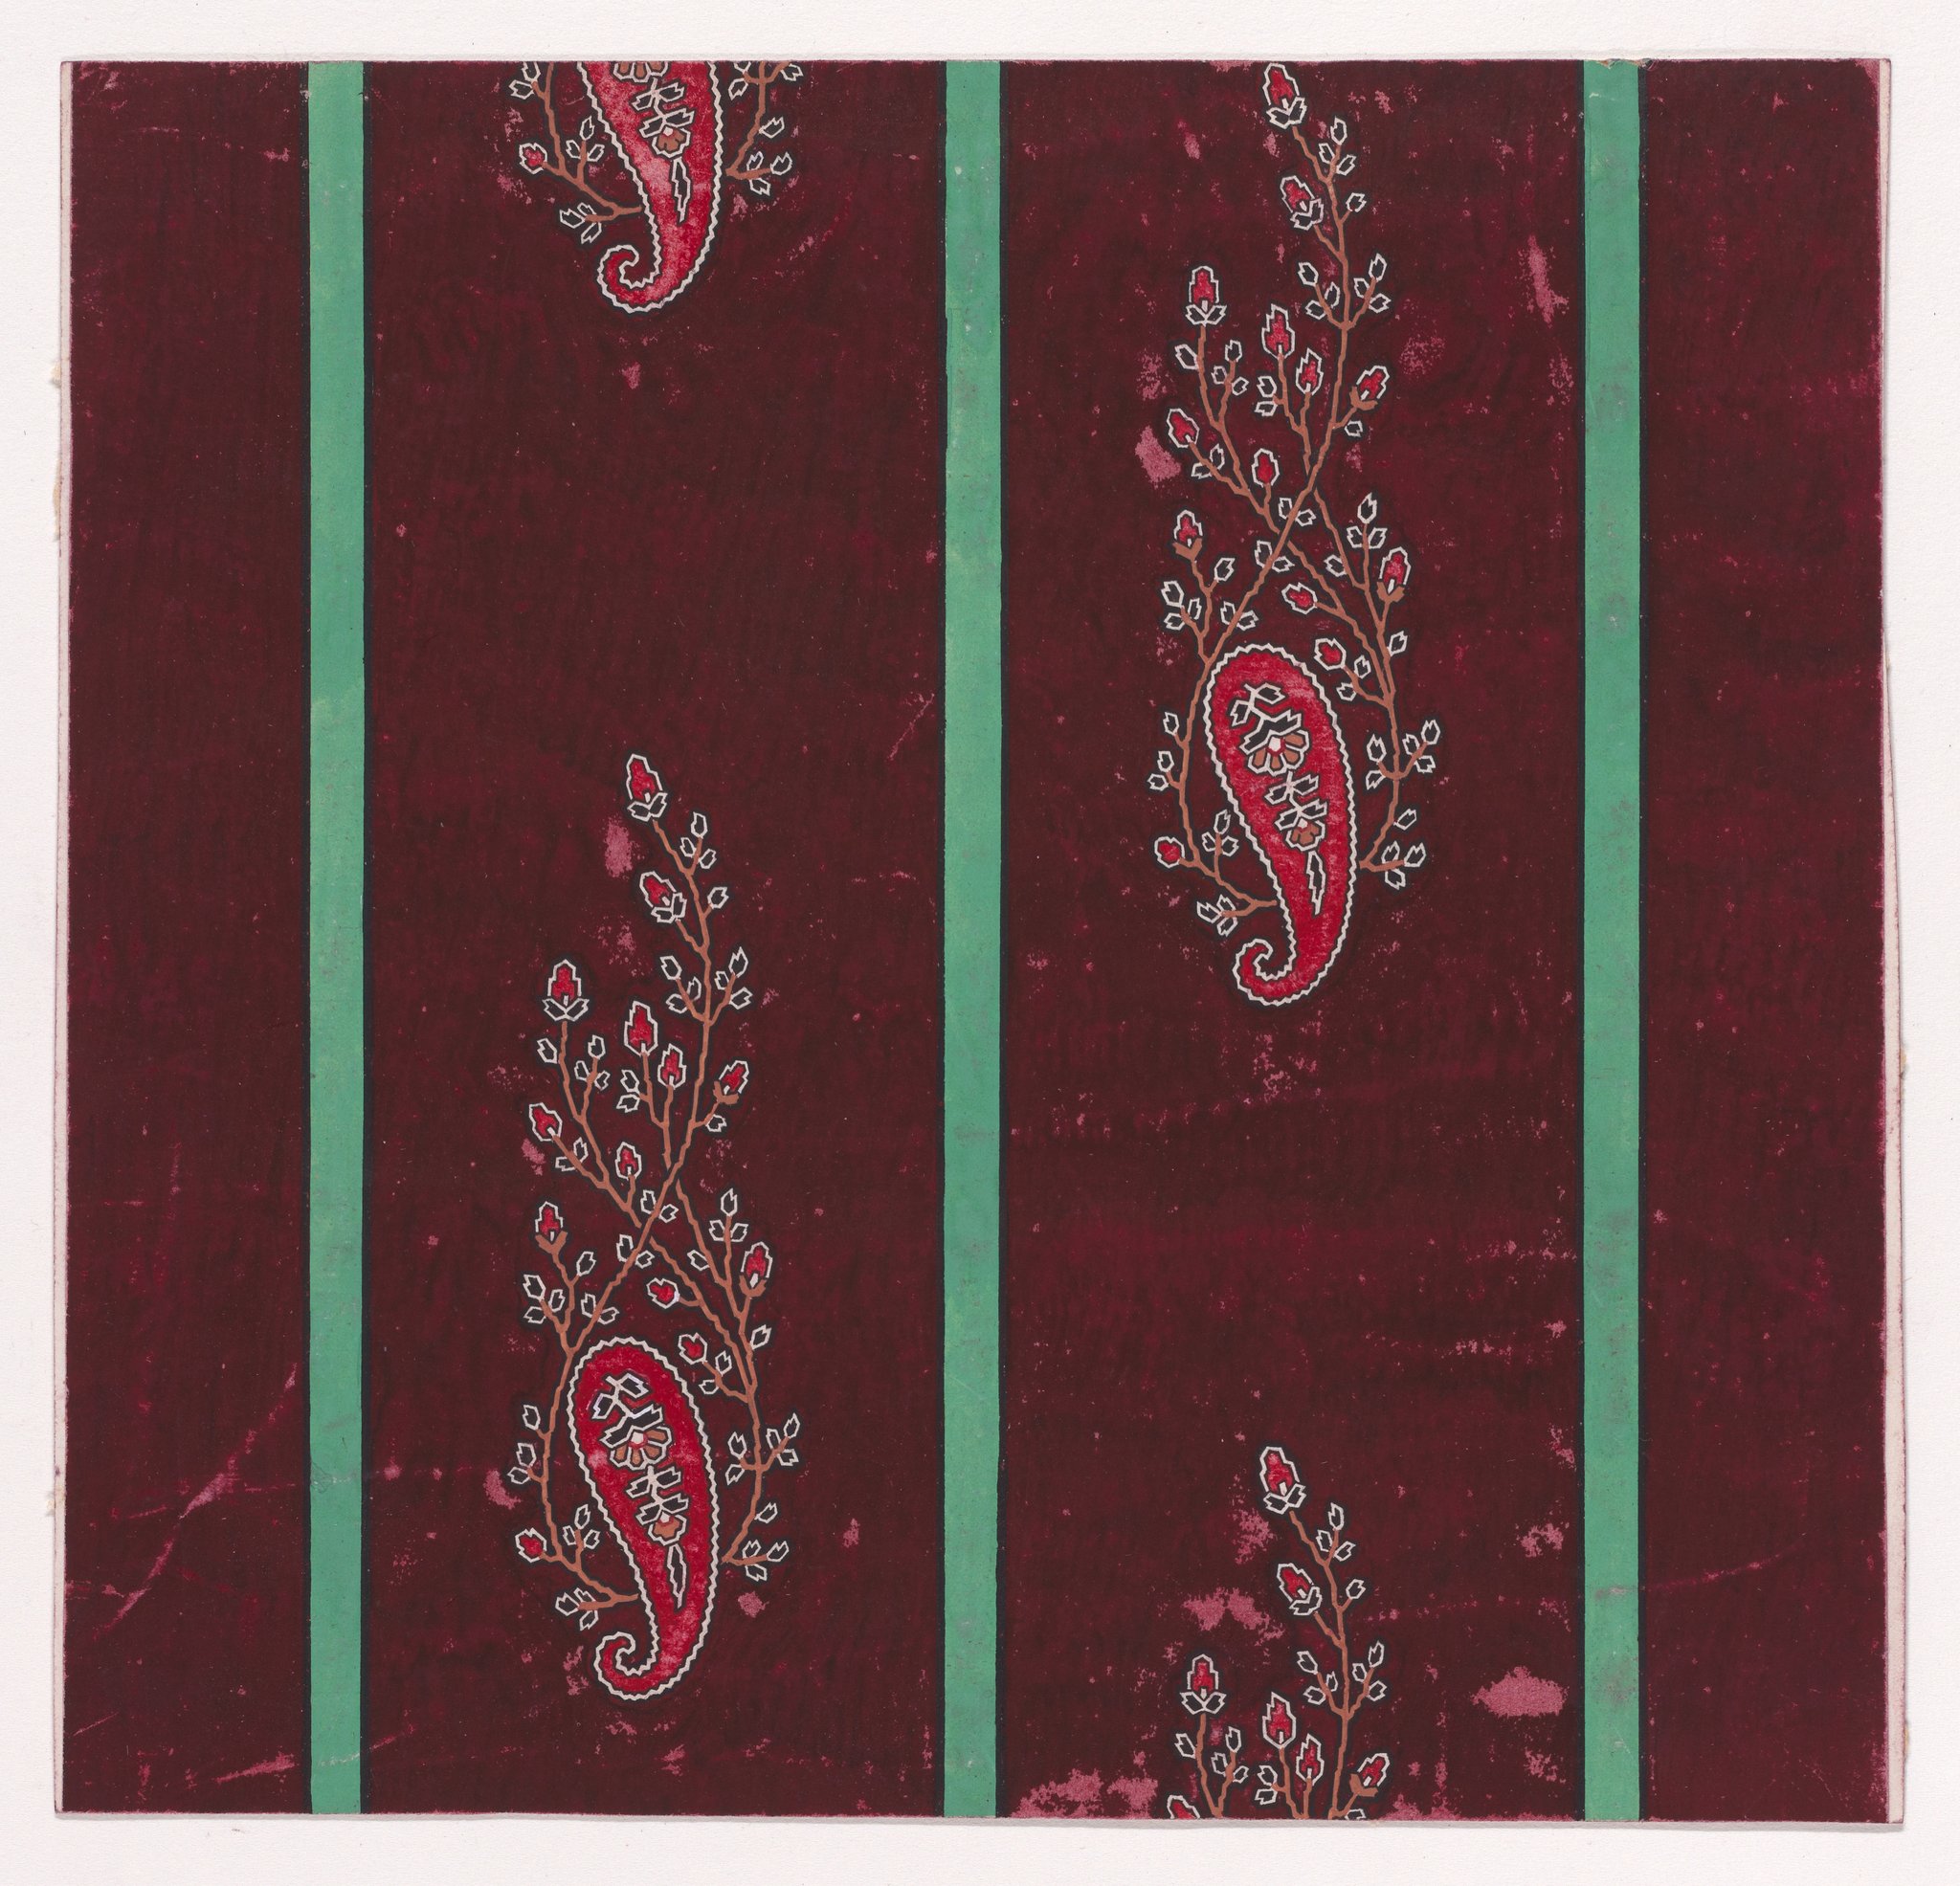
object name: drawing ornament architecture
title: Textile Design with Vertical Rows of Paisley Motifs Flanked by Interlacing Branches with Stylized Flowers and Leaves Separated by Stripes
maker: anonymous, alsatian, 19th century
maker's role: artist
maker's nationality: alsatian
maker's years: 1800-1900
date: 1840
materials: gouache